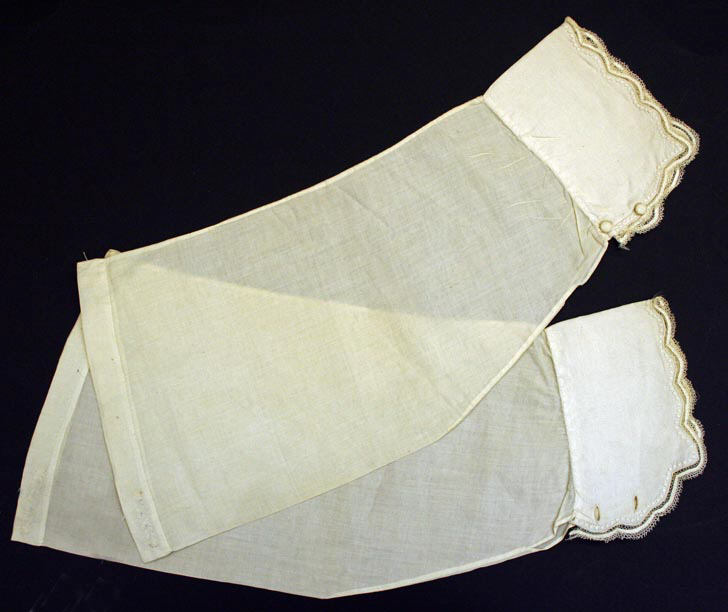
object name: undersleeves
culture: american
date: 1850-1879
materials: cotton